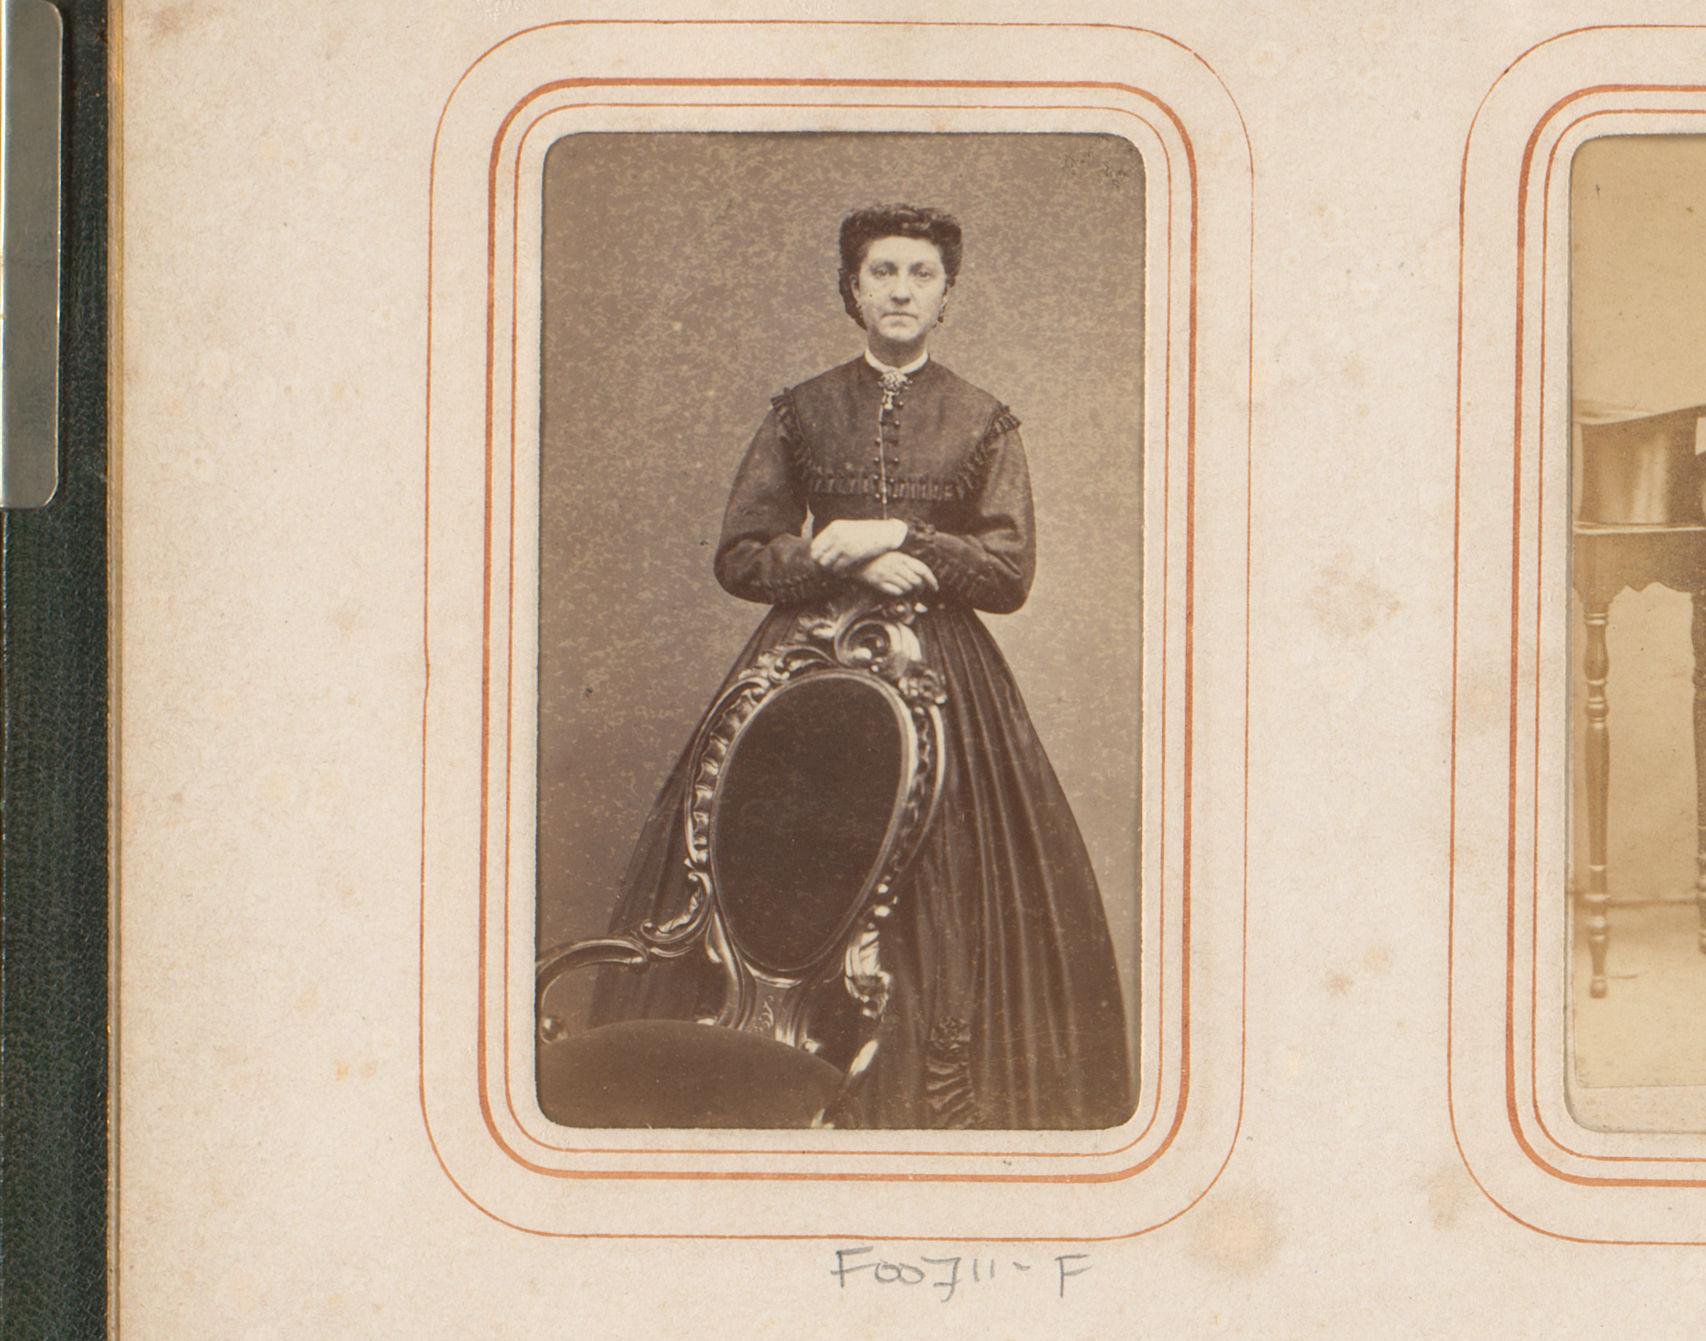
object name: photograph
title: Portret van een staande vrouw bij een stoel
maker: hermanus jodocus weesing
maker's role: fotograaf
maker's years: 1844-1910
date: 1868-1900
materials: cardboard, photographic support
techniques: albumen print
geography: amsterdam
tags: historical persons - bb - woman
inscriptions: inscription: ‘Photographisch Atelier/ H.J. Weesing/ Binnen Brouwerstraat T.T. 220/ Amsterdam’